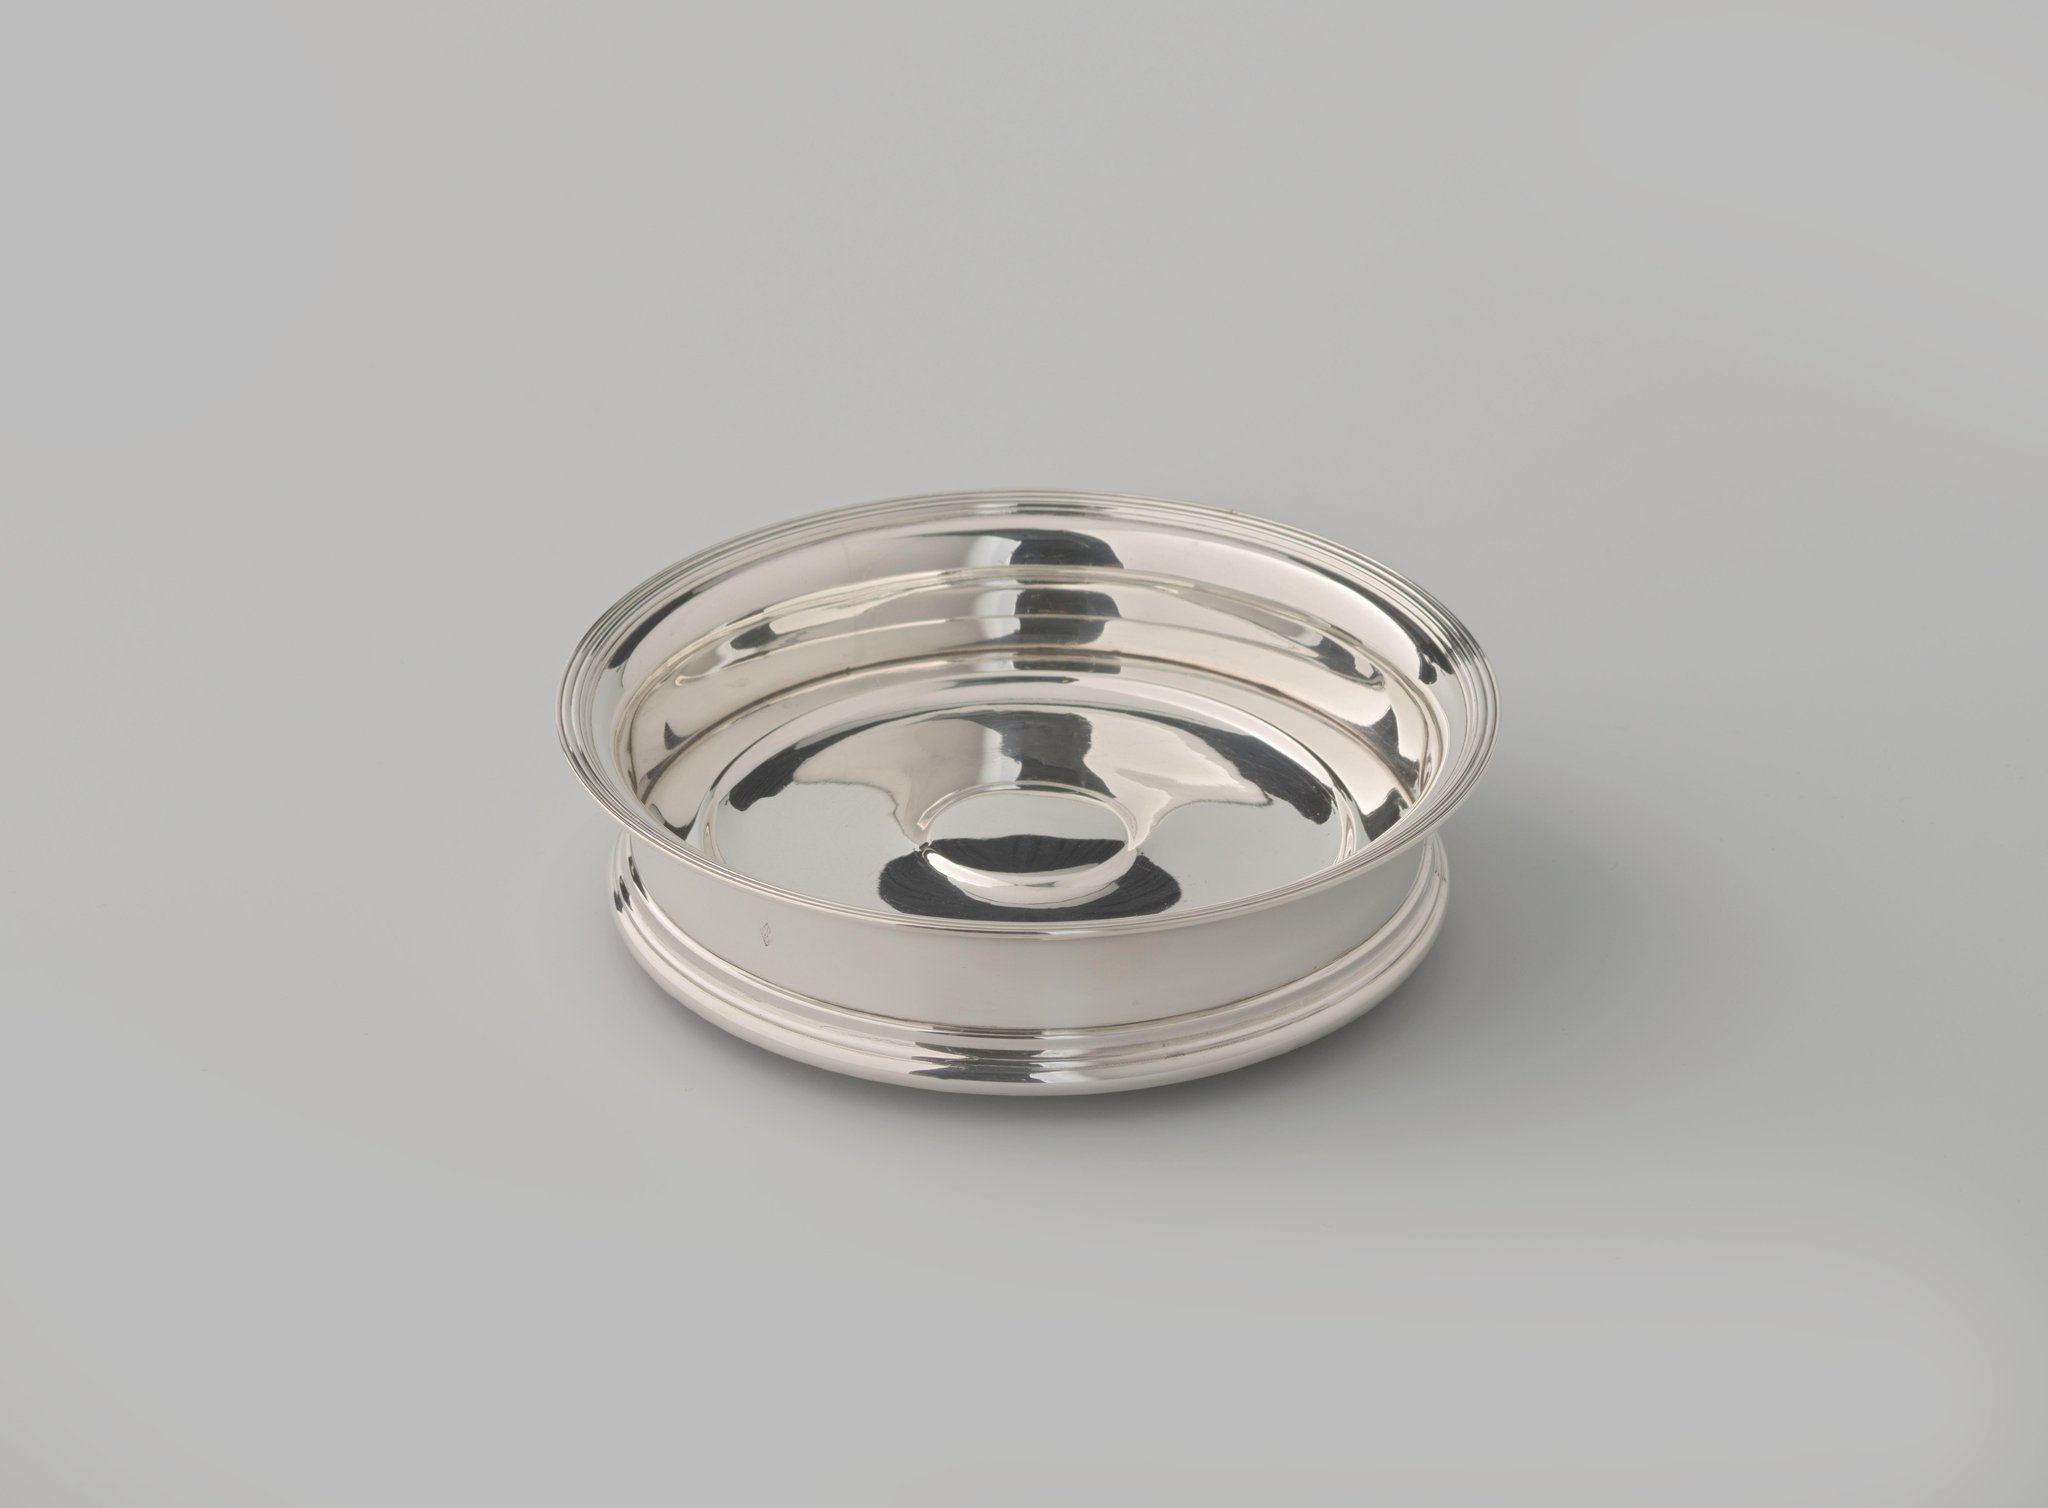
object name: wine coaster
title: Ronde flessenbak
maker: diederik lodewijk bennewitz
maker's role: silversmith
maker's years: 1763-1826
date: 1816-1819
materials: wood, silver, velvet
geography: amsterdam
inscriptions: : ‘minervakop met A’, maker's mark: ‘DLB’, alloy mark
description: De flessenbak heeft een vlakke bodem met een verhoging in het midden en een opstaande naar boven uitgebogen gladde wand. Langs de onder- en de bovenzijde zijn filetranden aangebracht. Onder de bodem is een mahoniehouten klos aangebracht, waarop een rand groen fluweel is gelijmd.